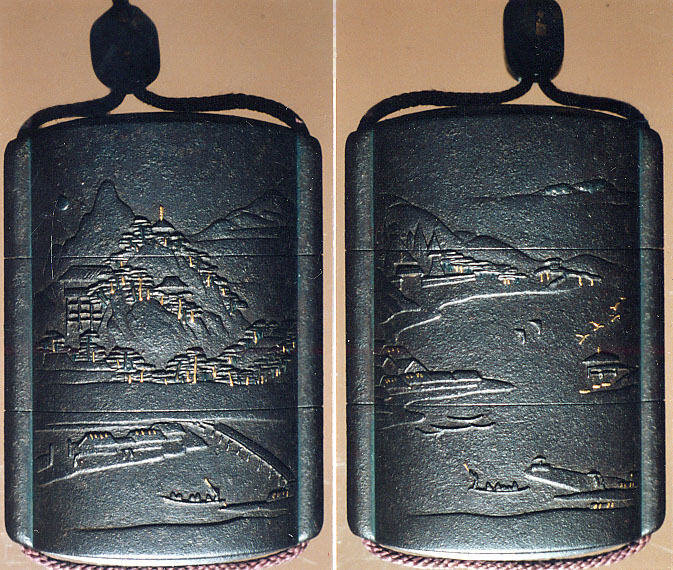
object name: inrō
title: Case (Inrō) with Design of Mountain Landscape and Geese Flying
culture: japanese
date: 1701-1800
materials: gold, iron, metal, silver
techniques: relief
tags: mountains,landscapes